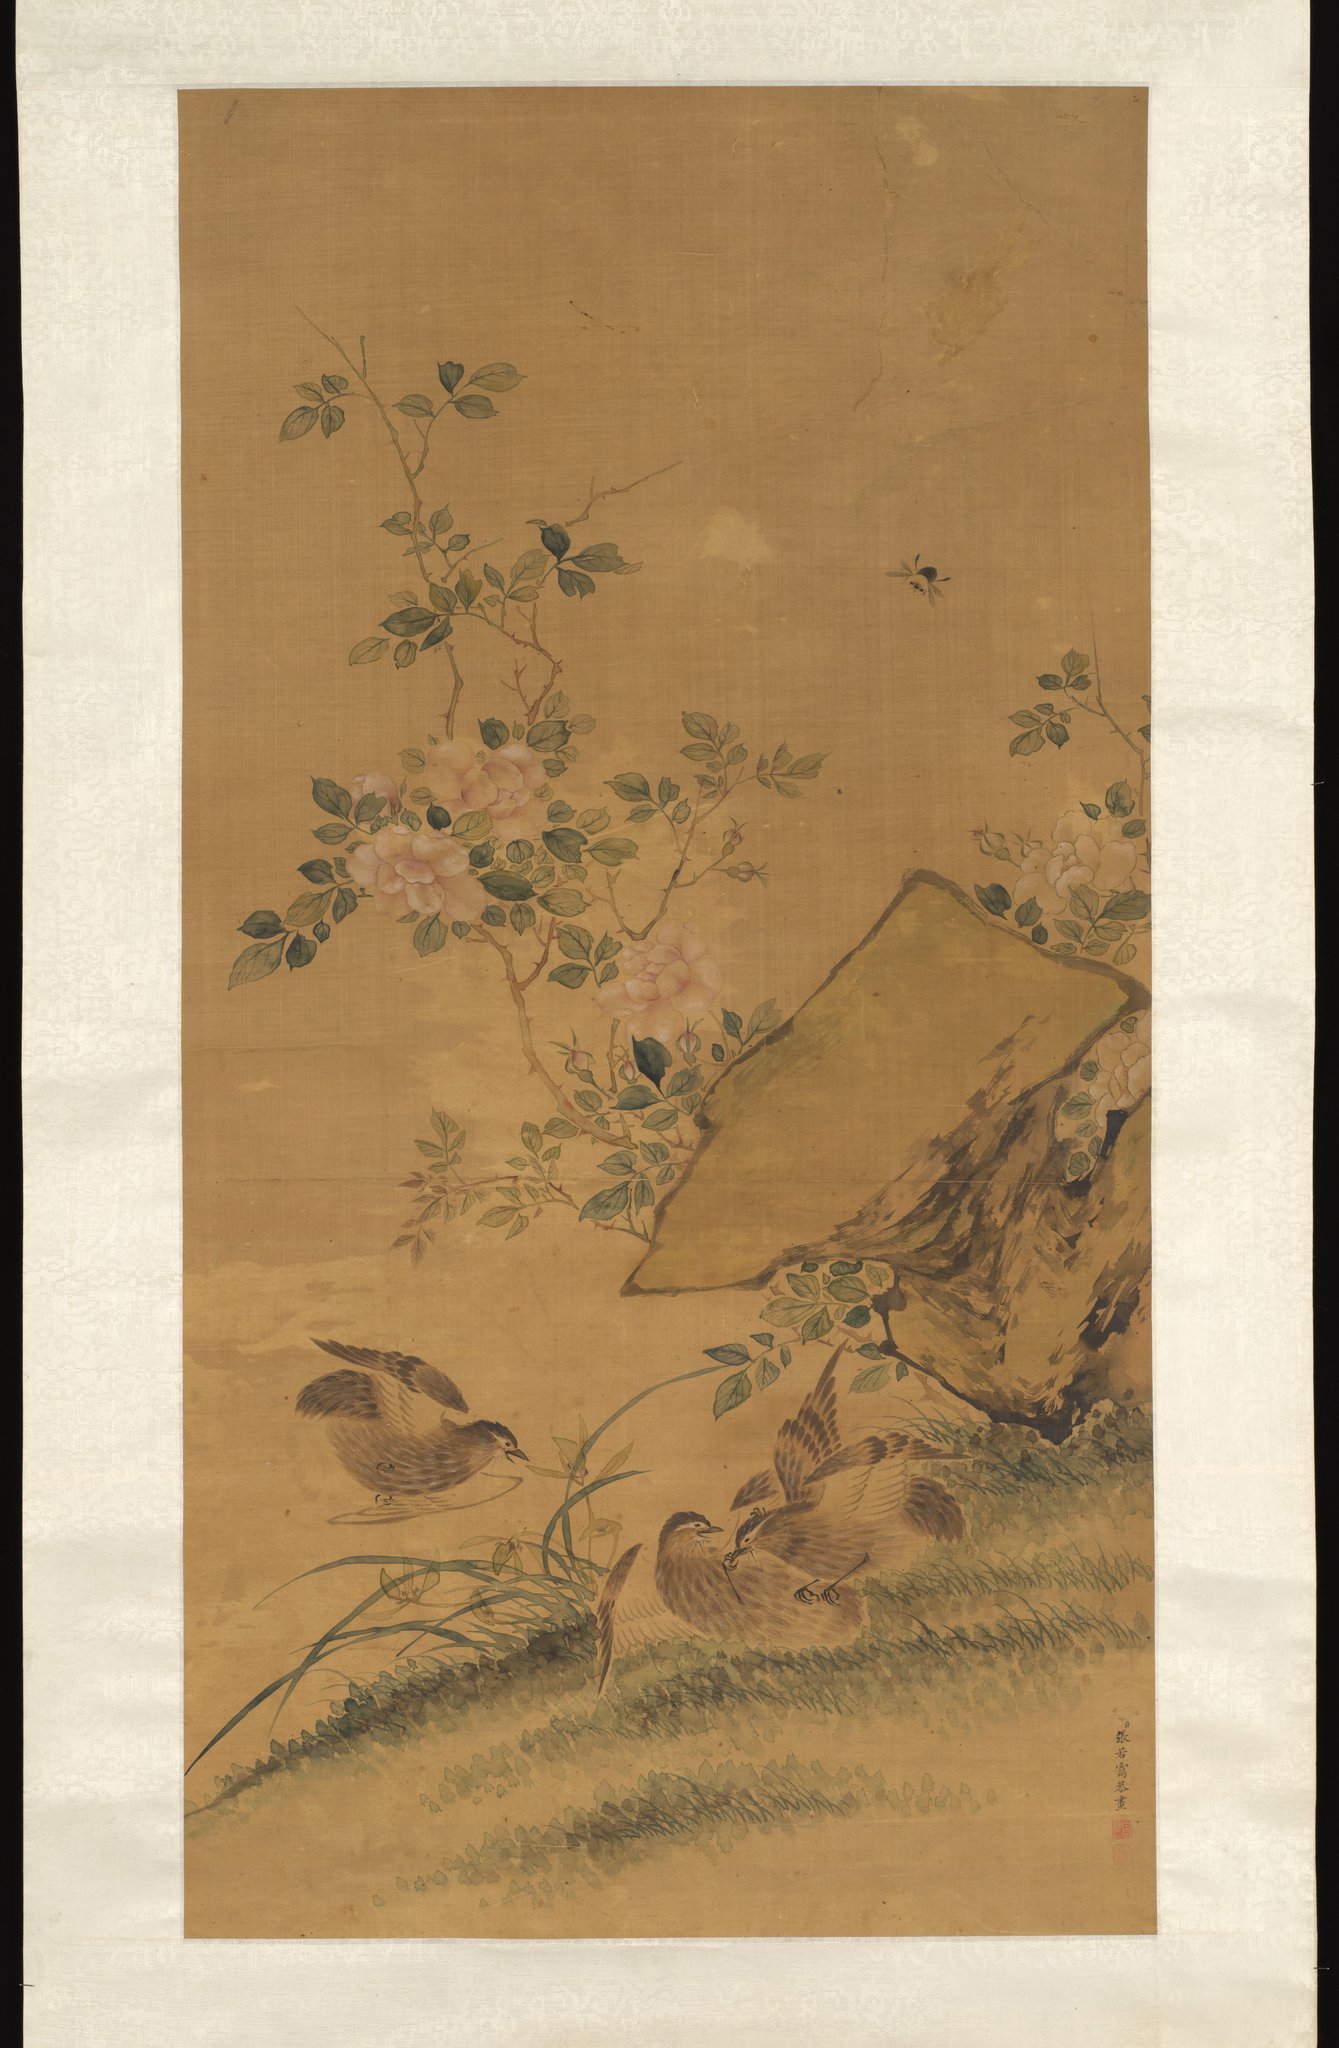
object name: hanging scroll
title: Flowers and Birds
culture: chinese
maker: zhang ruoai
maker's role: artist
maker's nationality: chinese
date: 1701-1733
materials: ink, silk